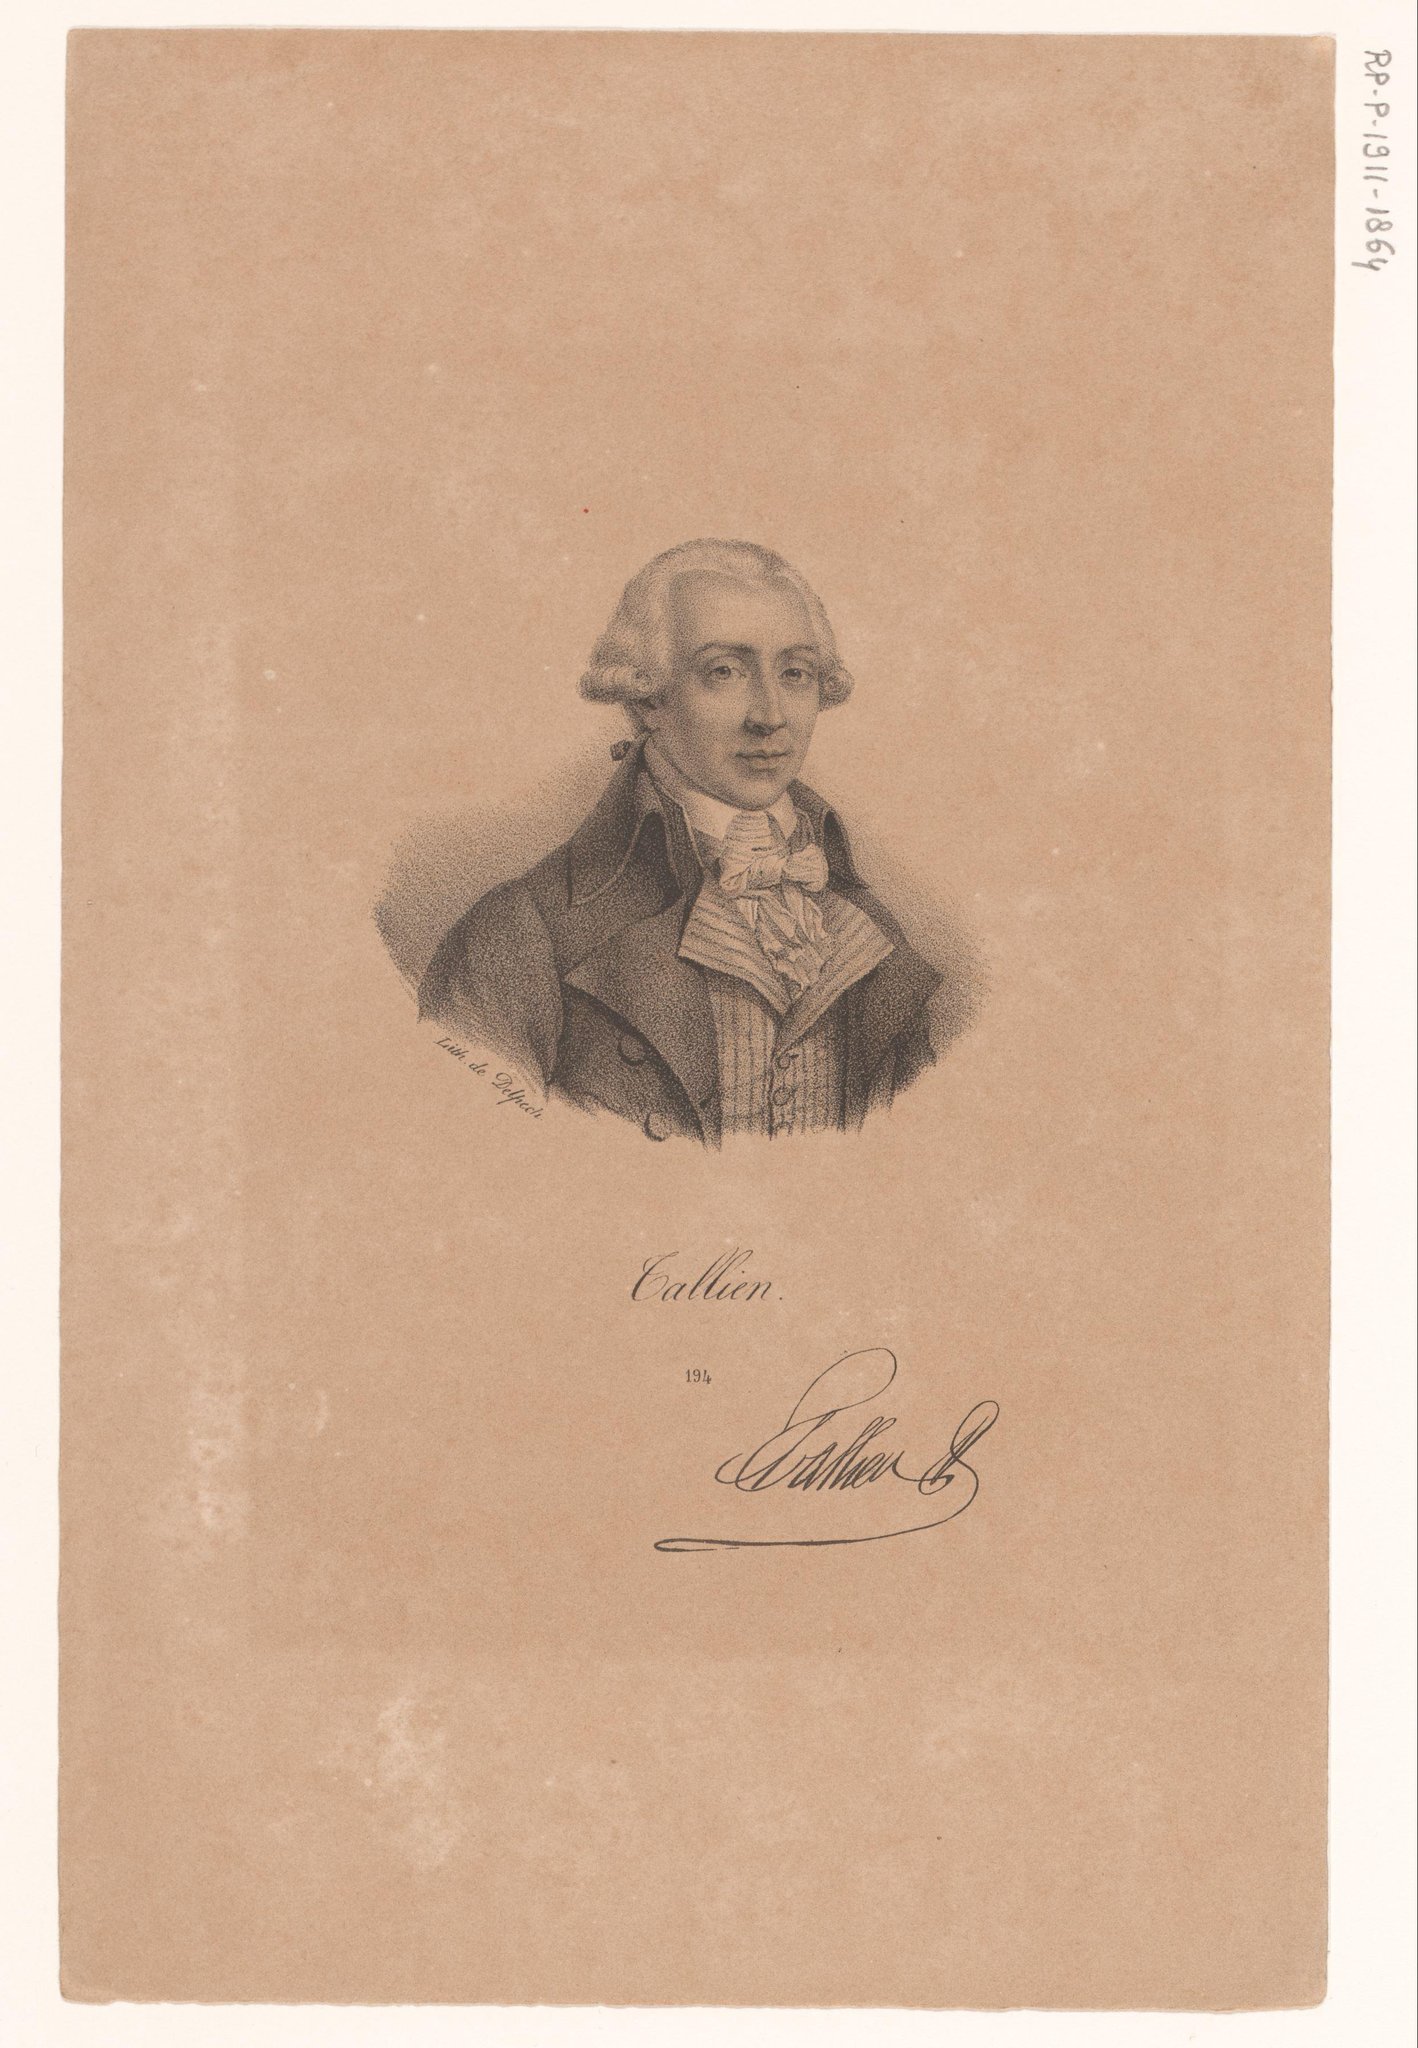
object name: print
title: Tallien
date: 1818-1842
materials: paper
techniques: lithograph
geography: paris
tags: historical persons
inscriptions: collector's mark: Lugt 2228a